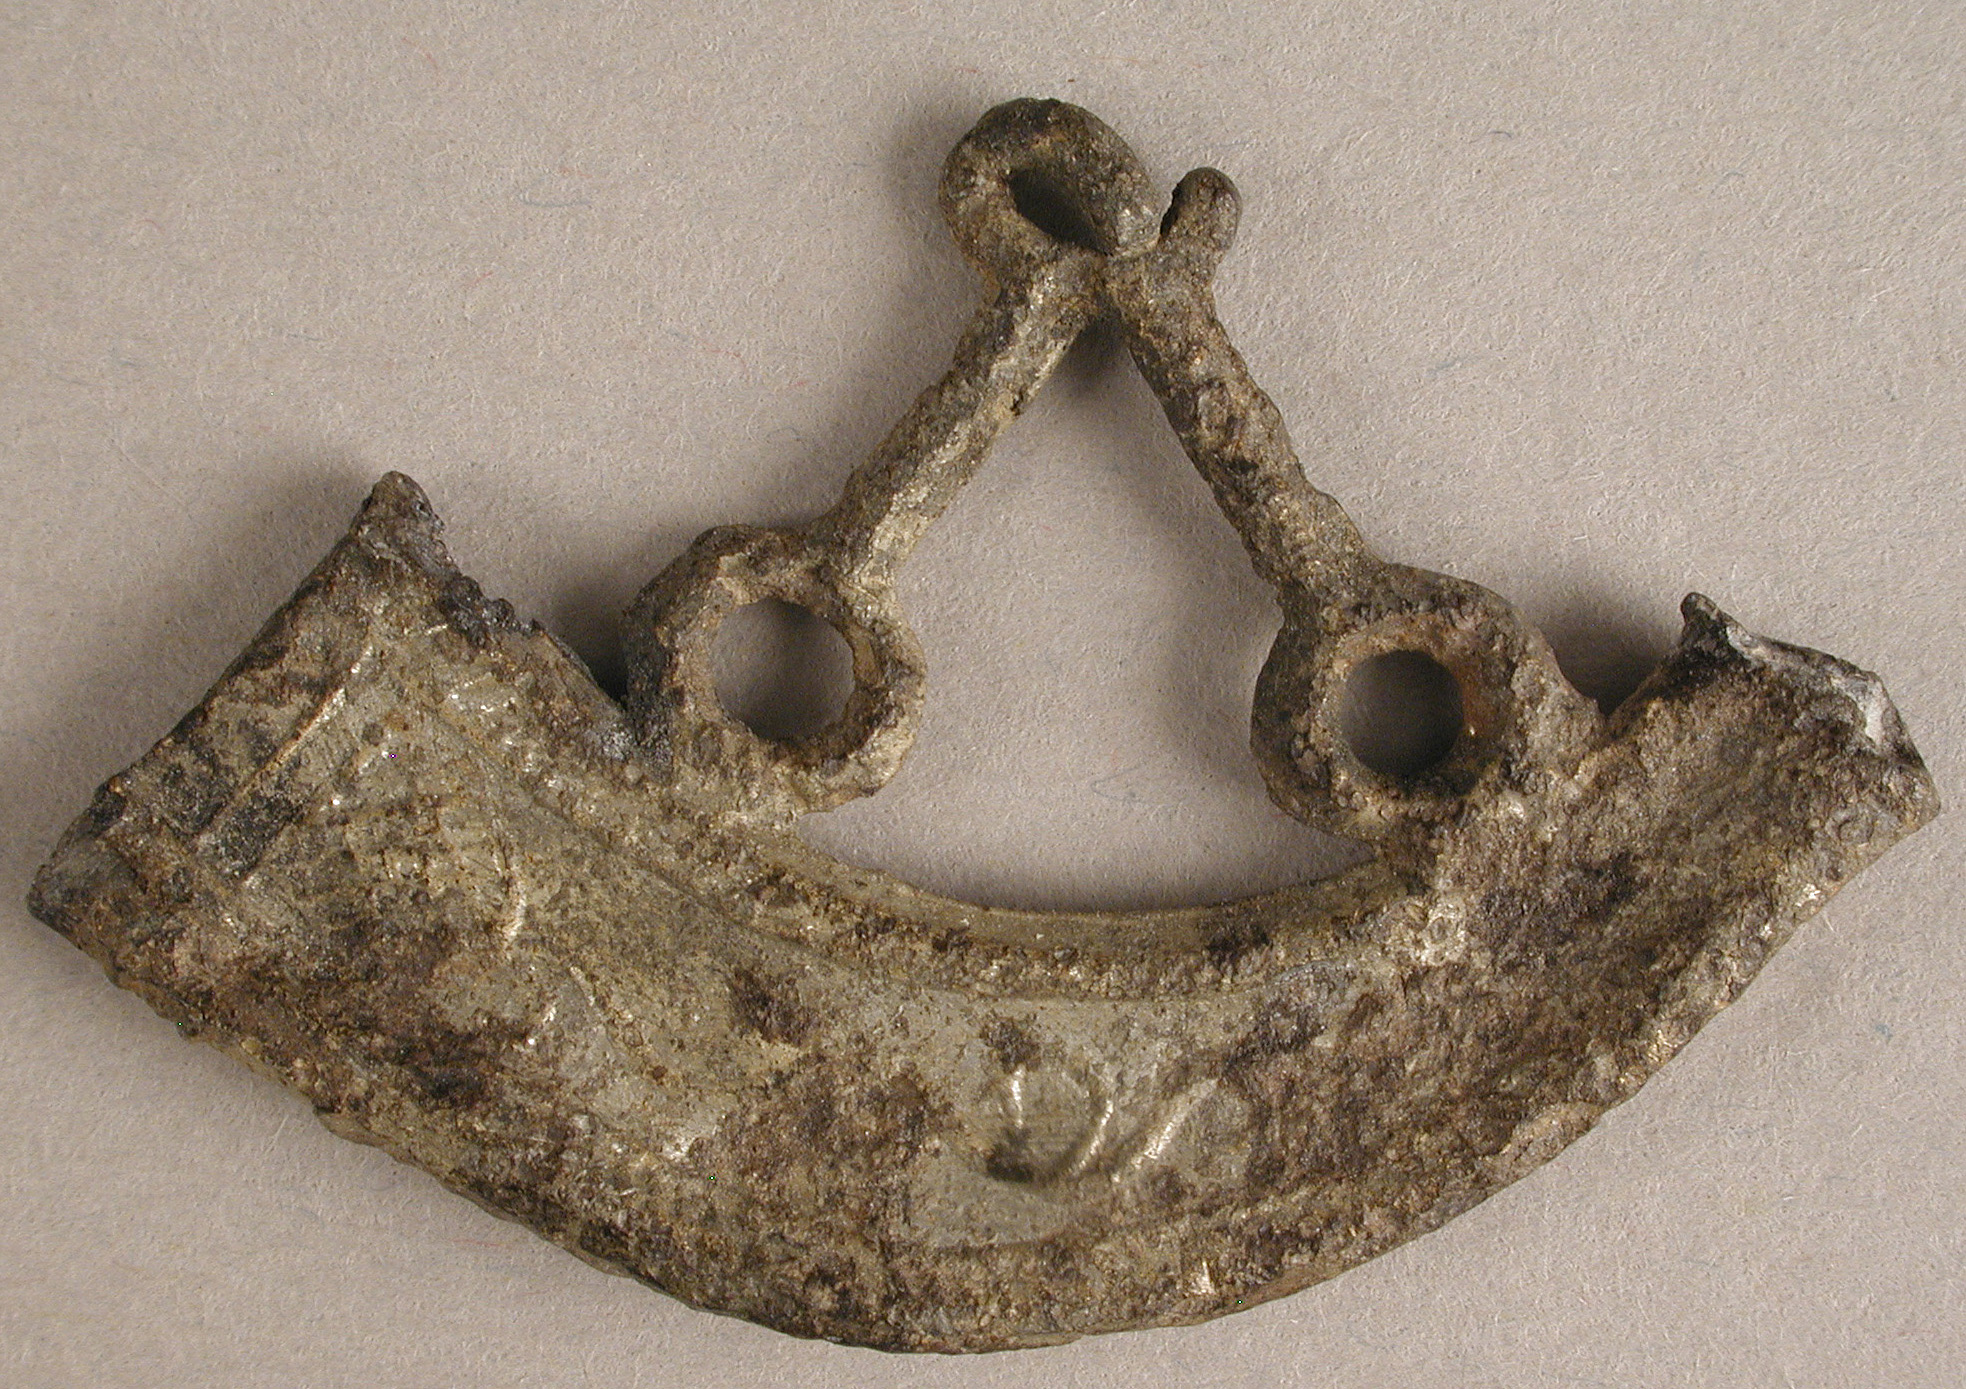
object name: pilgrim's badge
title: Badge with Hunting Horn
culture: british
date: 1401-1500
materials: alloy, lead, tin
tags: horns